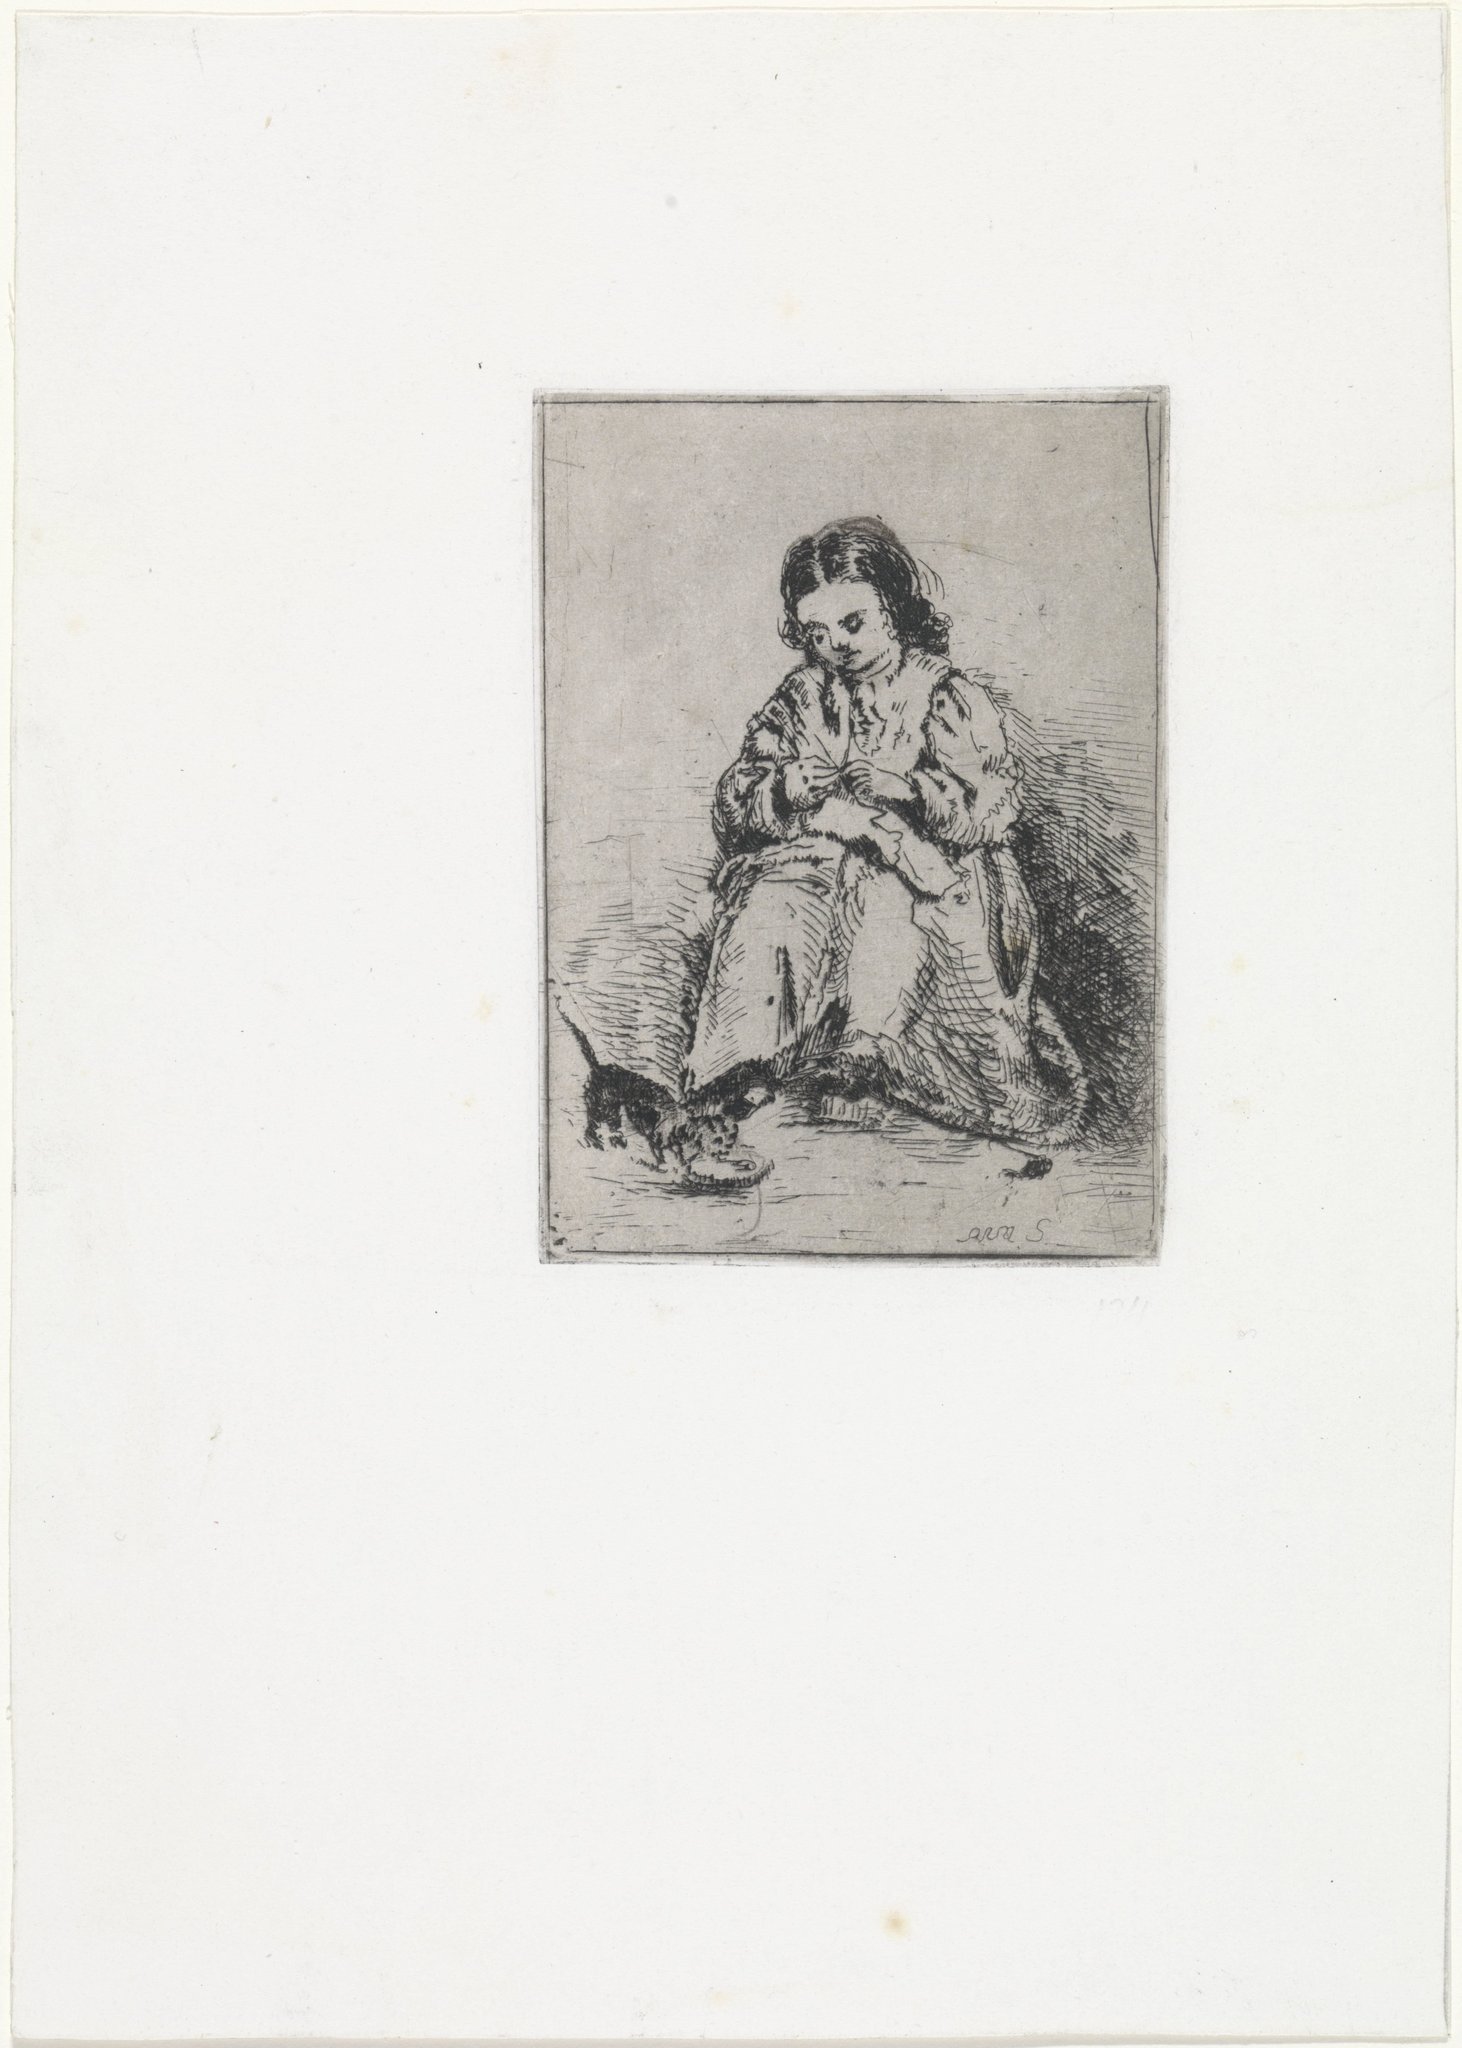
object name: print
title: Zittend meisje met breiwerk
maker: arnoud schaepkens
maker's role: print maker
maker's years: 1816-1904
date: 1855-1904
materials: paper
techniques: drypoint, etching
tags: knitting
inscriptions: collector's mark: Lugt 2228